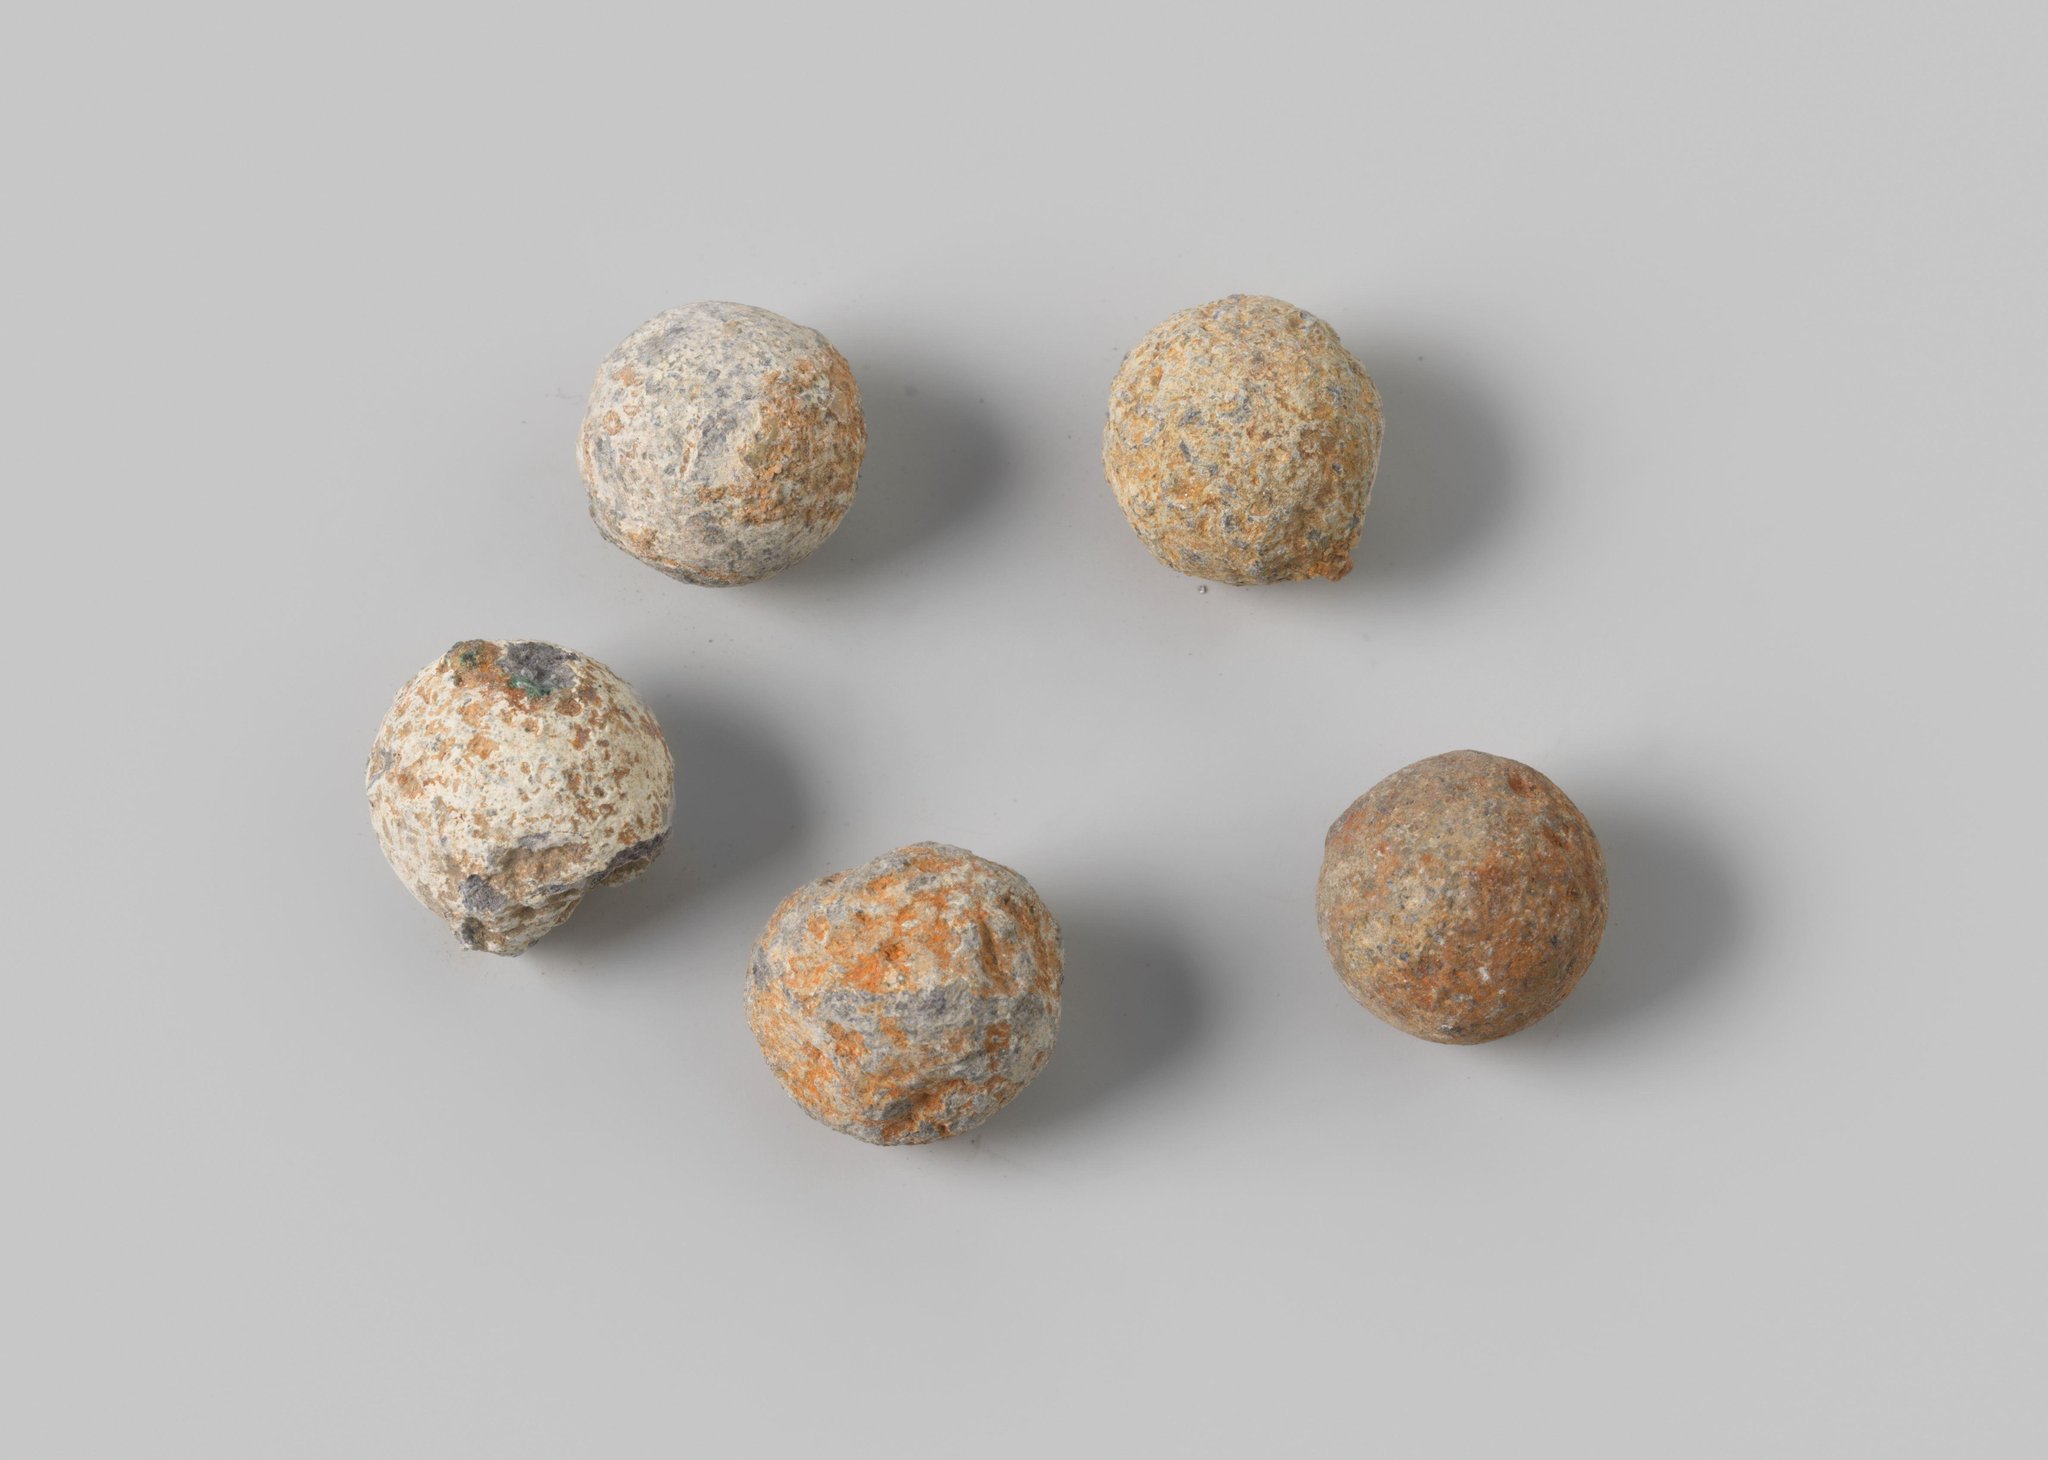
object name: musketkogel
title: Musketkogels uit het wrak van de Oost-Indiëvaarder Hollandia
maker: Anonymous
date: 1700-1743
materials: lead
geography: netherlands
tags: verenigde oostindische compagnie, hollandia (schip), annet